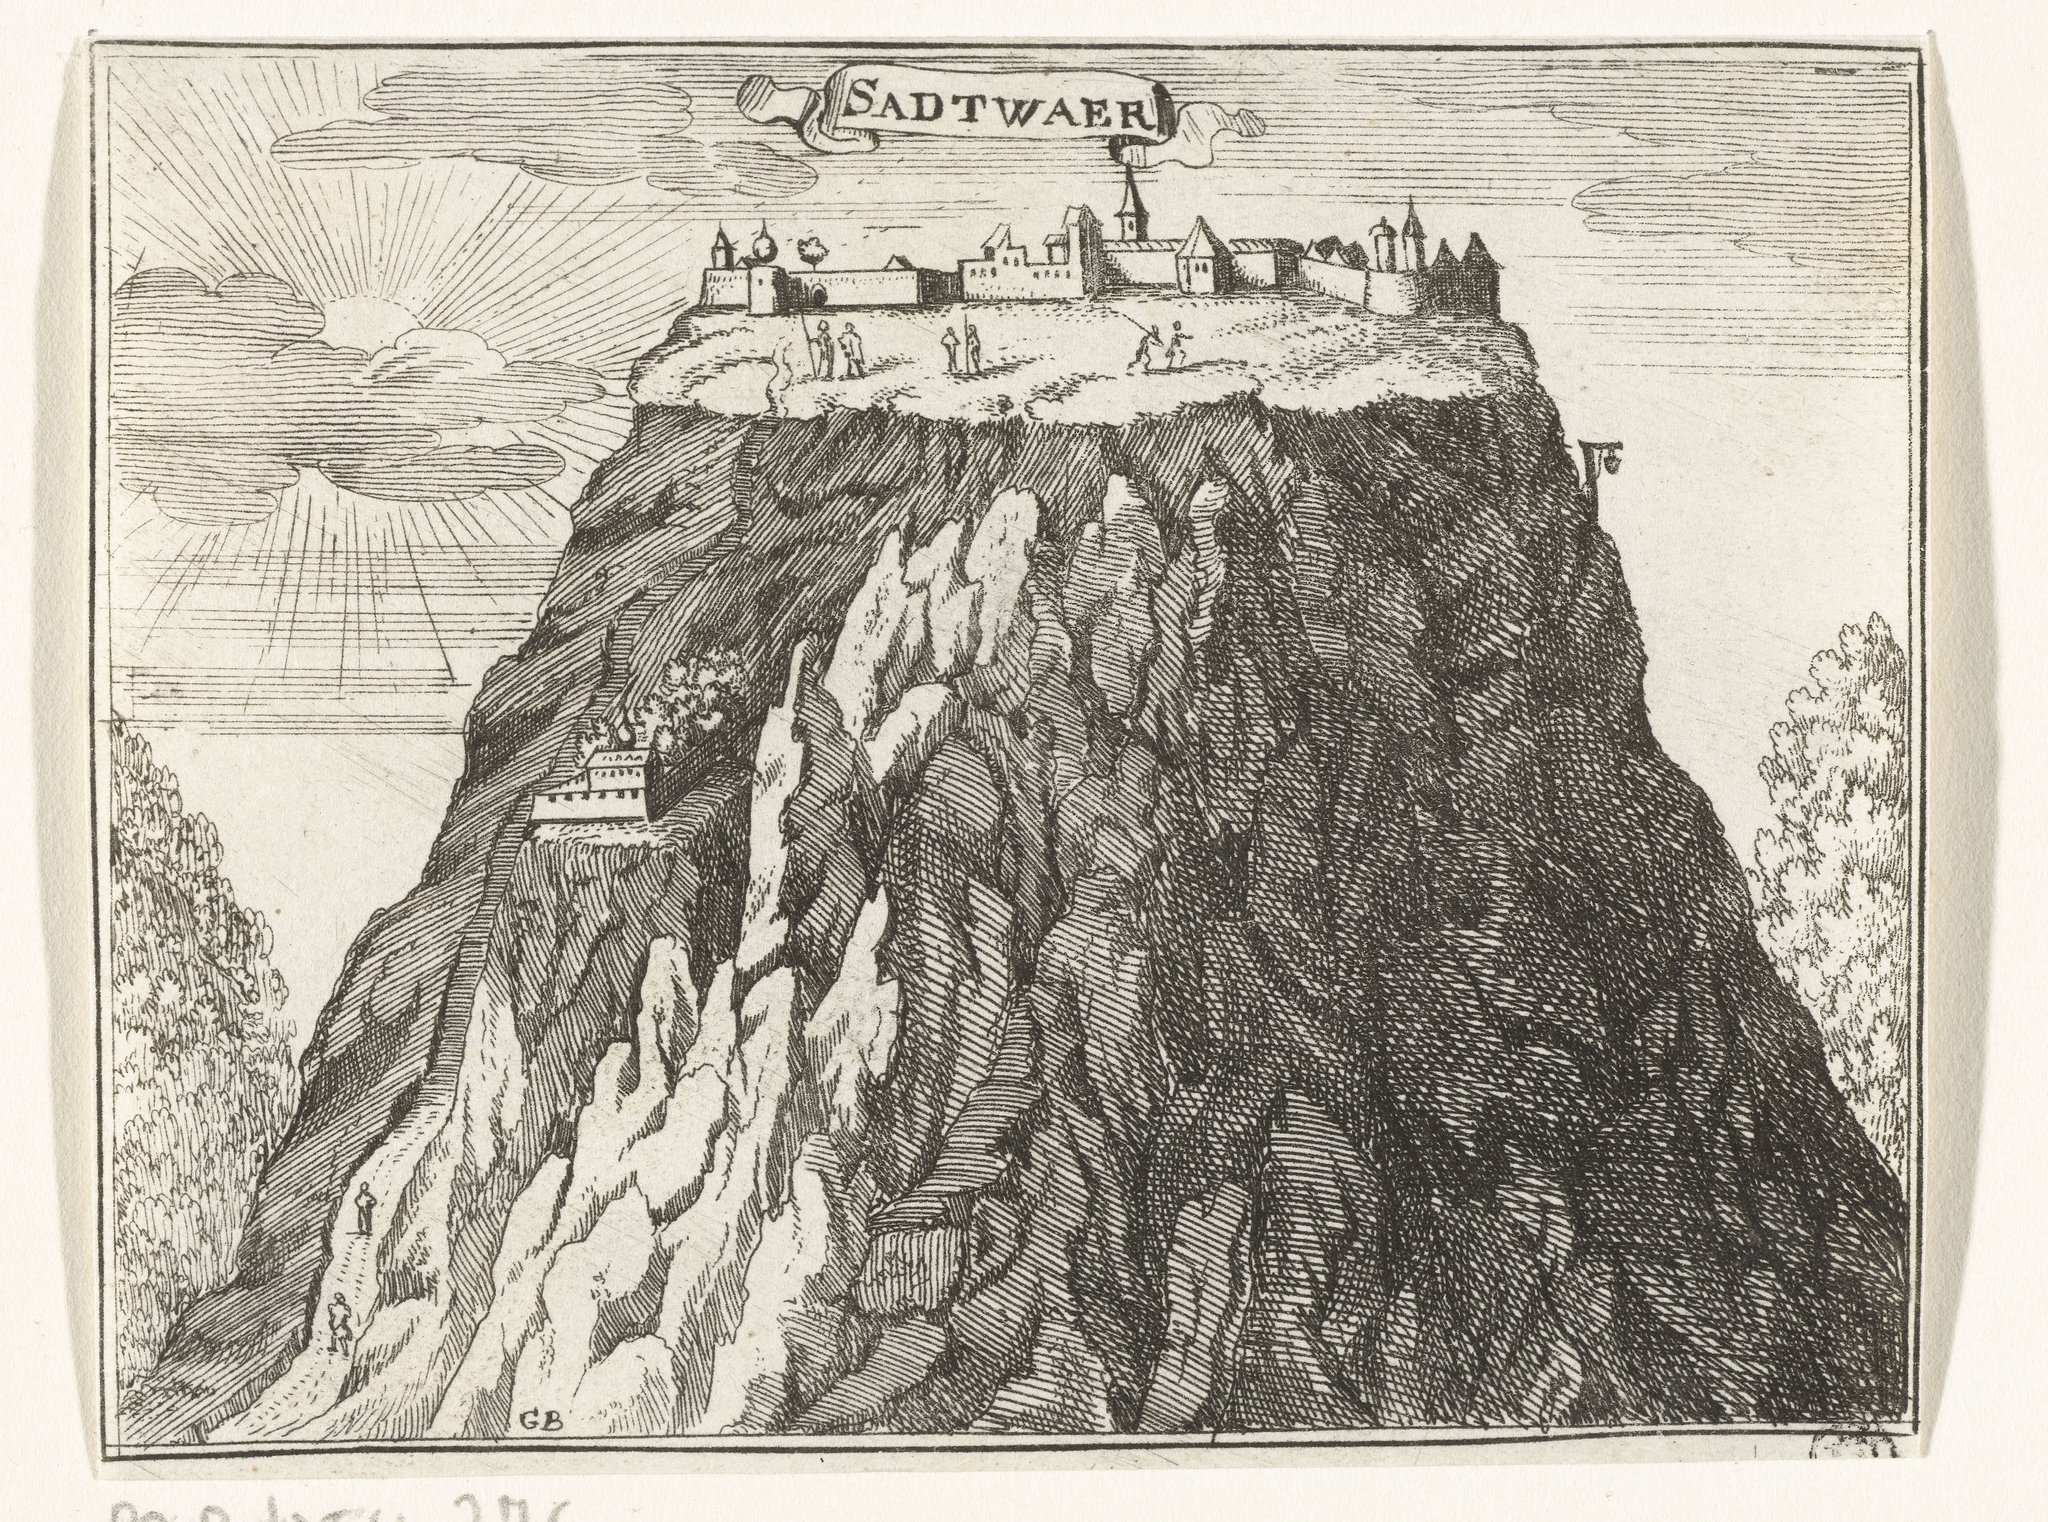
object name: print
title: Gezicht op Szádvár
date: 1686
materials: paper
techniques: etching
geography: antwerp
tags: prospect of city, town panorama, silhouette of city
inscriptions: collector's mark: Lugt 2228, collector's mark: Lugt 2760, collector's mark: Lugt 971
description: illustriatie voor J. Peeters en C. Bouttats, "Korte beschryvinghe, en de aen-wysinghe der plaetsen in desen boeck, met hunnen teghen woordighen standt, pertinentelijk uyt-ghebeldt, in Oostenryck", Antwerpen 1686.